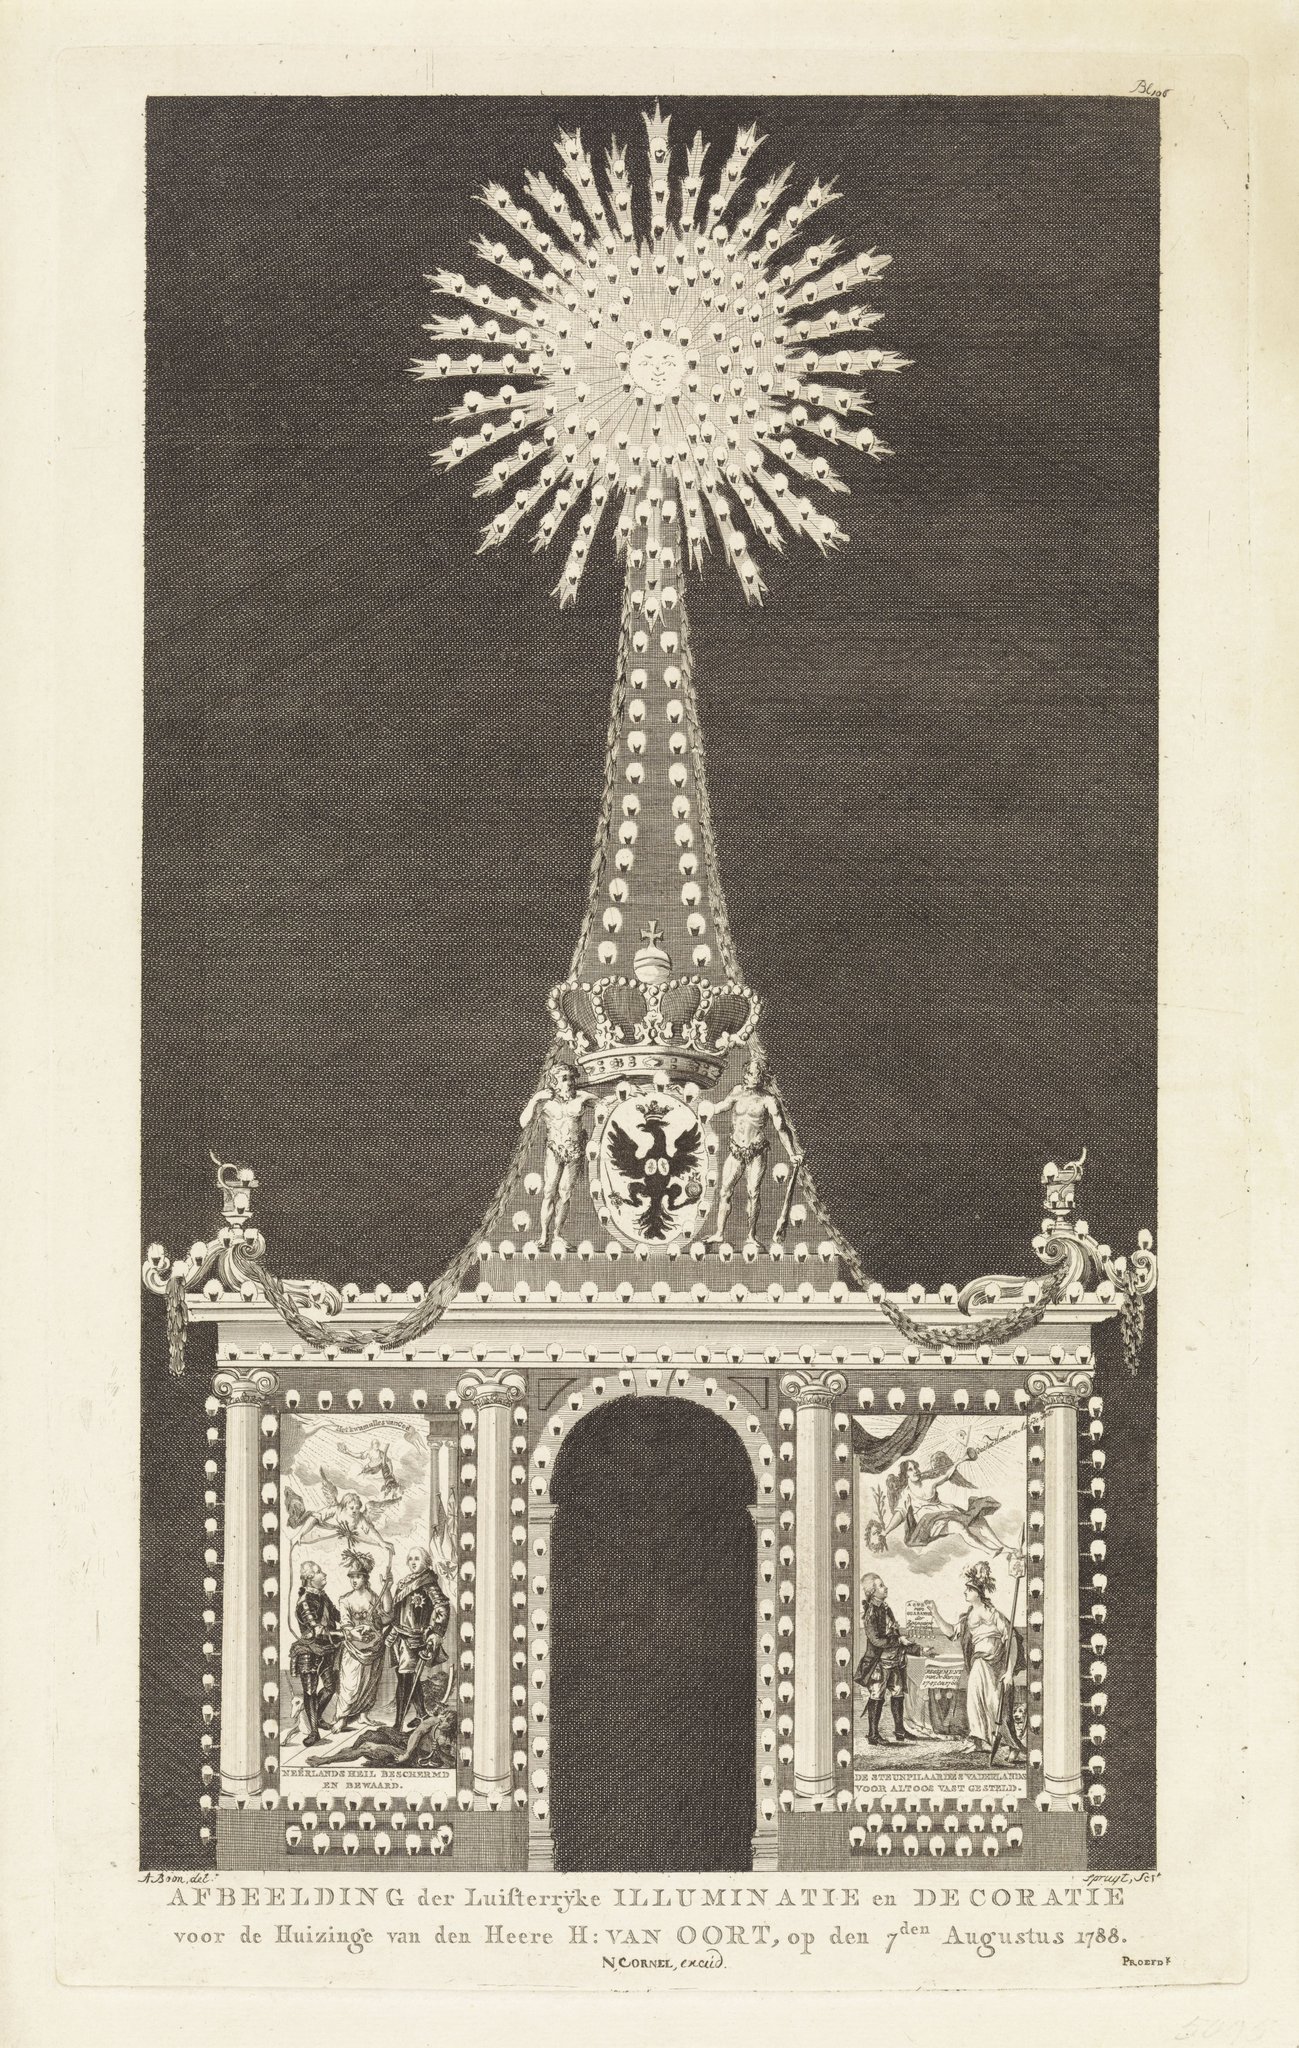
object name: print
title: Afbeelding der Luisterrijke Illuminatie en Decoratie voor de Huizinge van den Heere H: van Oort, op den 7den Augustus 1788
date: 1788-1790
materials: paper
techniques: etching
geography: rotterdam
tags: public festivities at other royal events, not meant or mentioned above (+ illumination, fire-works ~ festive activities), rotterdam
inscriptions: collector's mark: Lugt 2228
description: Illuminatie voor het huis van H. van Oort te Rotterdam, ter gelegenheid van de verjaardag van prinses Wilhelmina van Pruisen op 7 augustus 1788. Twee chassinetten met allegorische voorstellingen. Gemerkt rechtsboven: Bl 106.